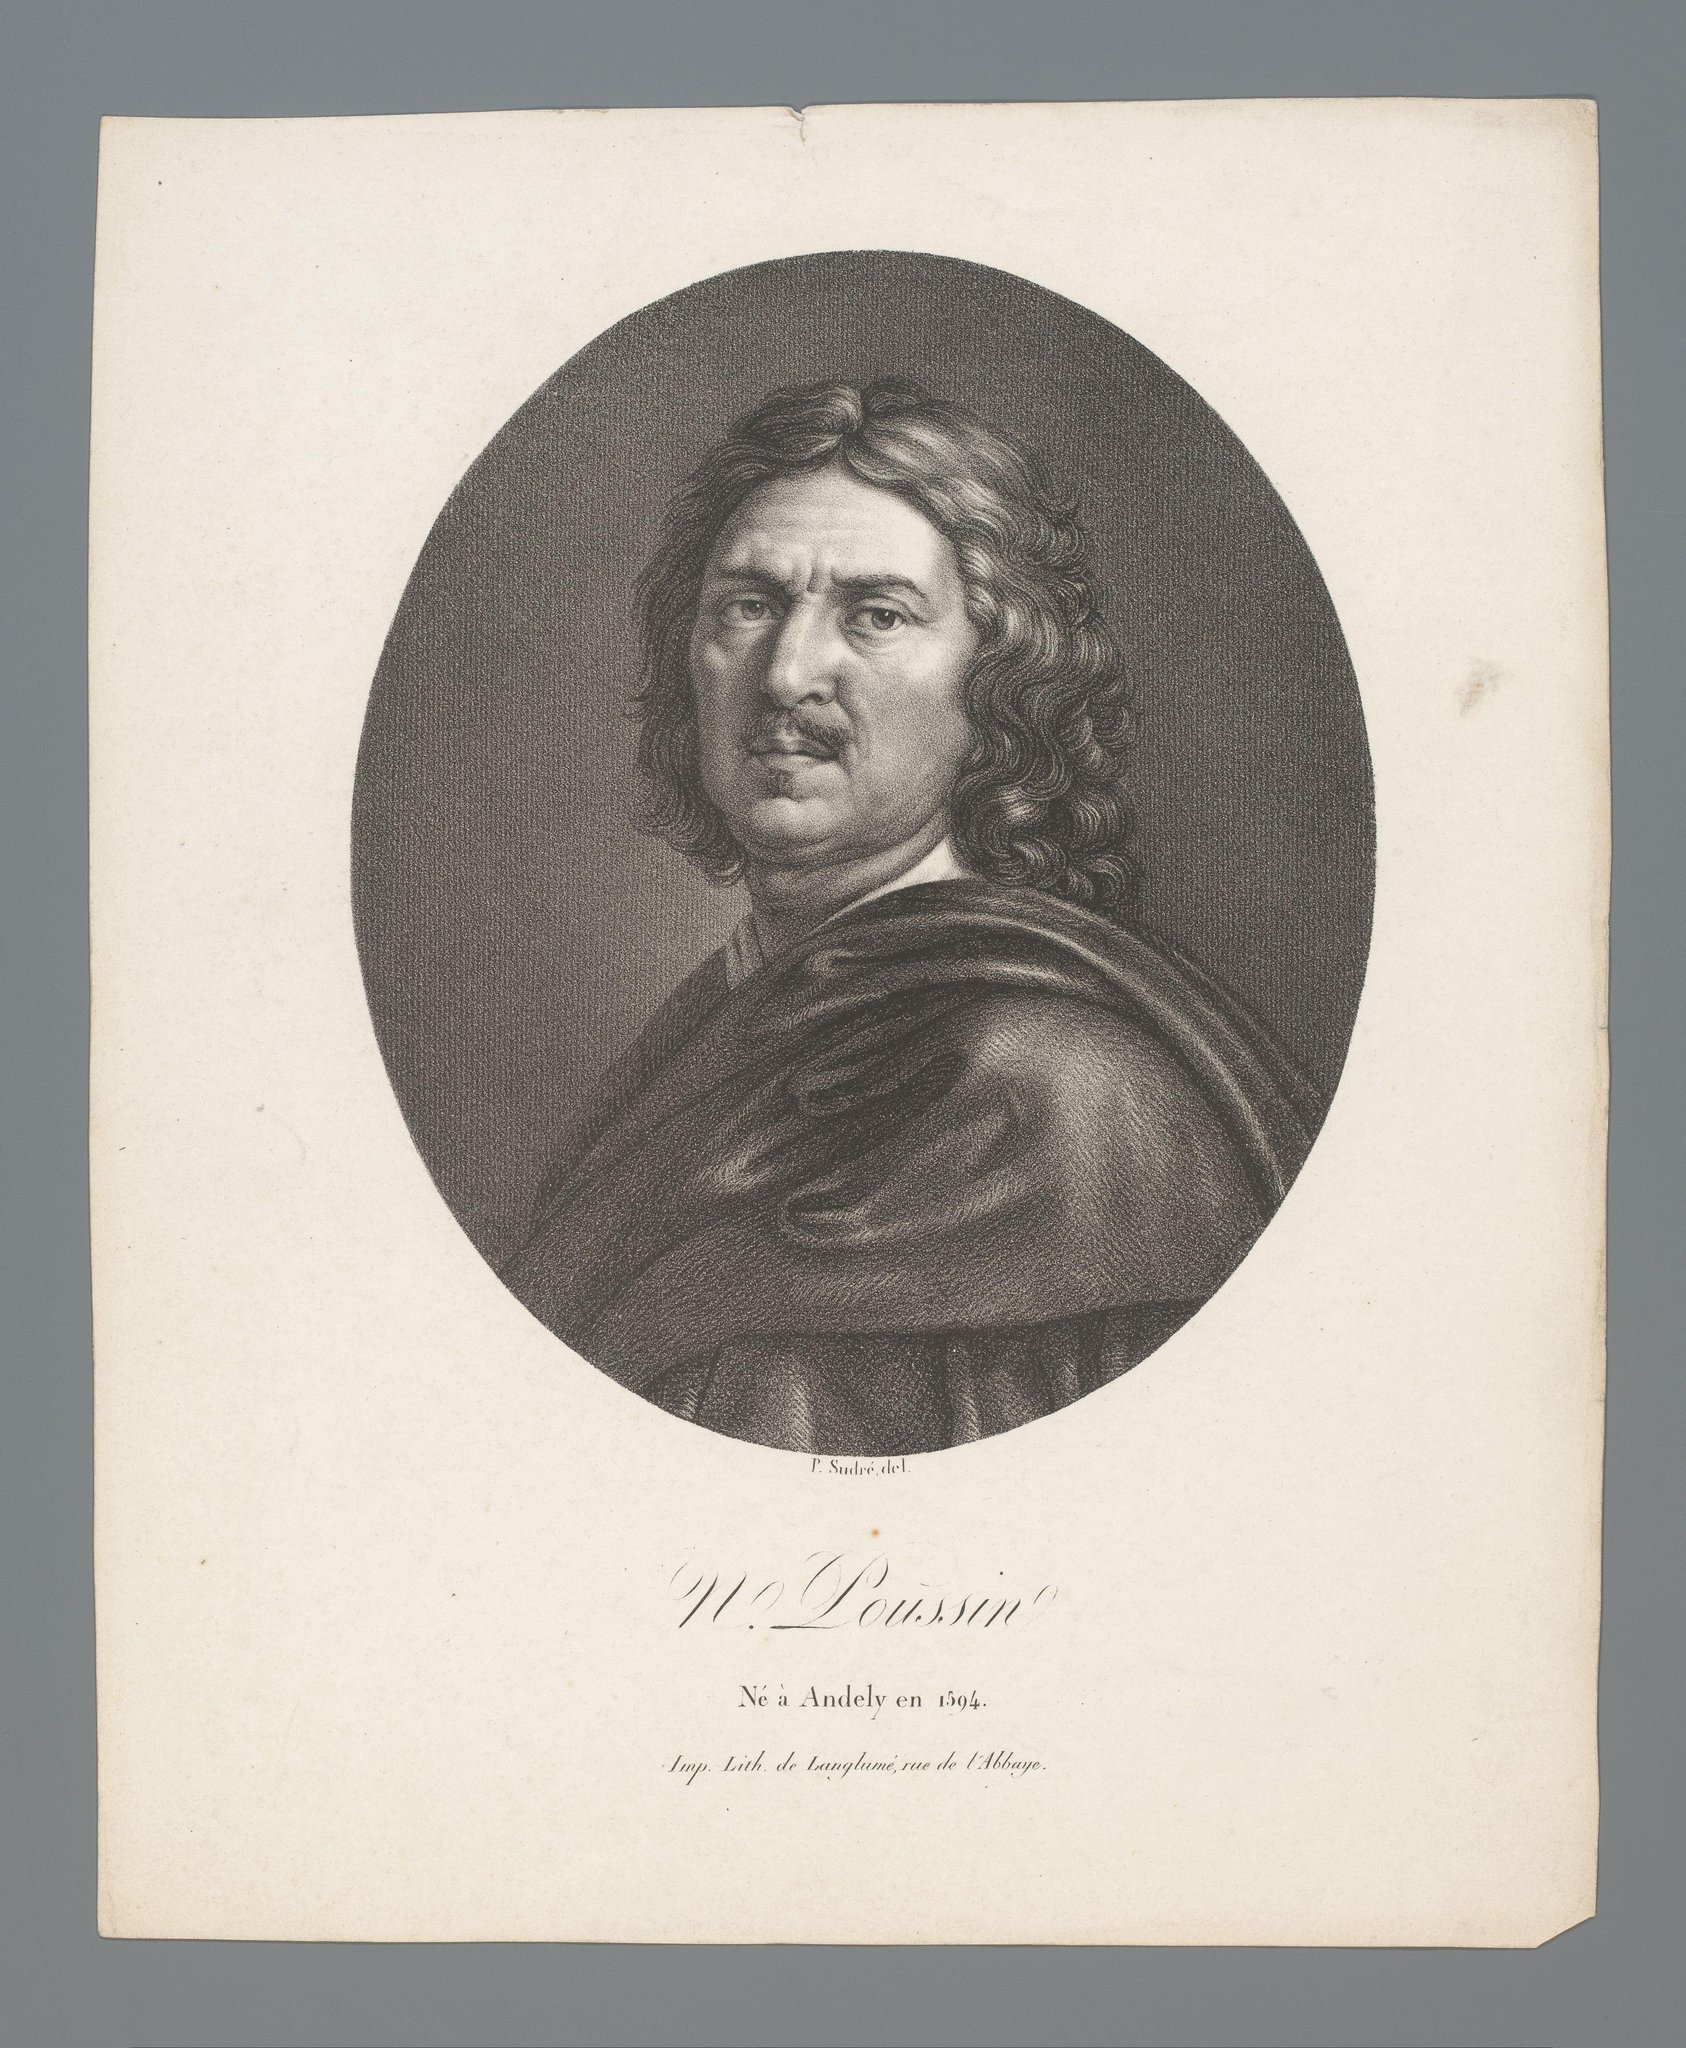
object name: print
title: Le panthéon français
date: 1822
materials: paper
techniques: lithograph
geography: paris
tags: rome, painter, draughtsman, nicolas poussin, historical persons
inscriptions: collector's mark: Lugt 2228